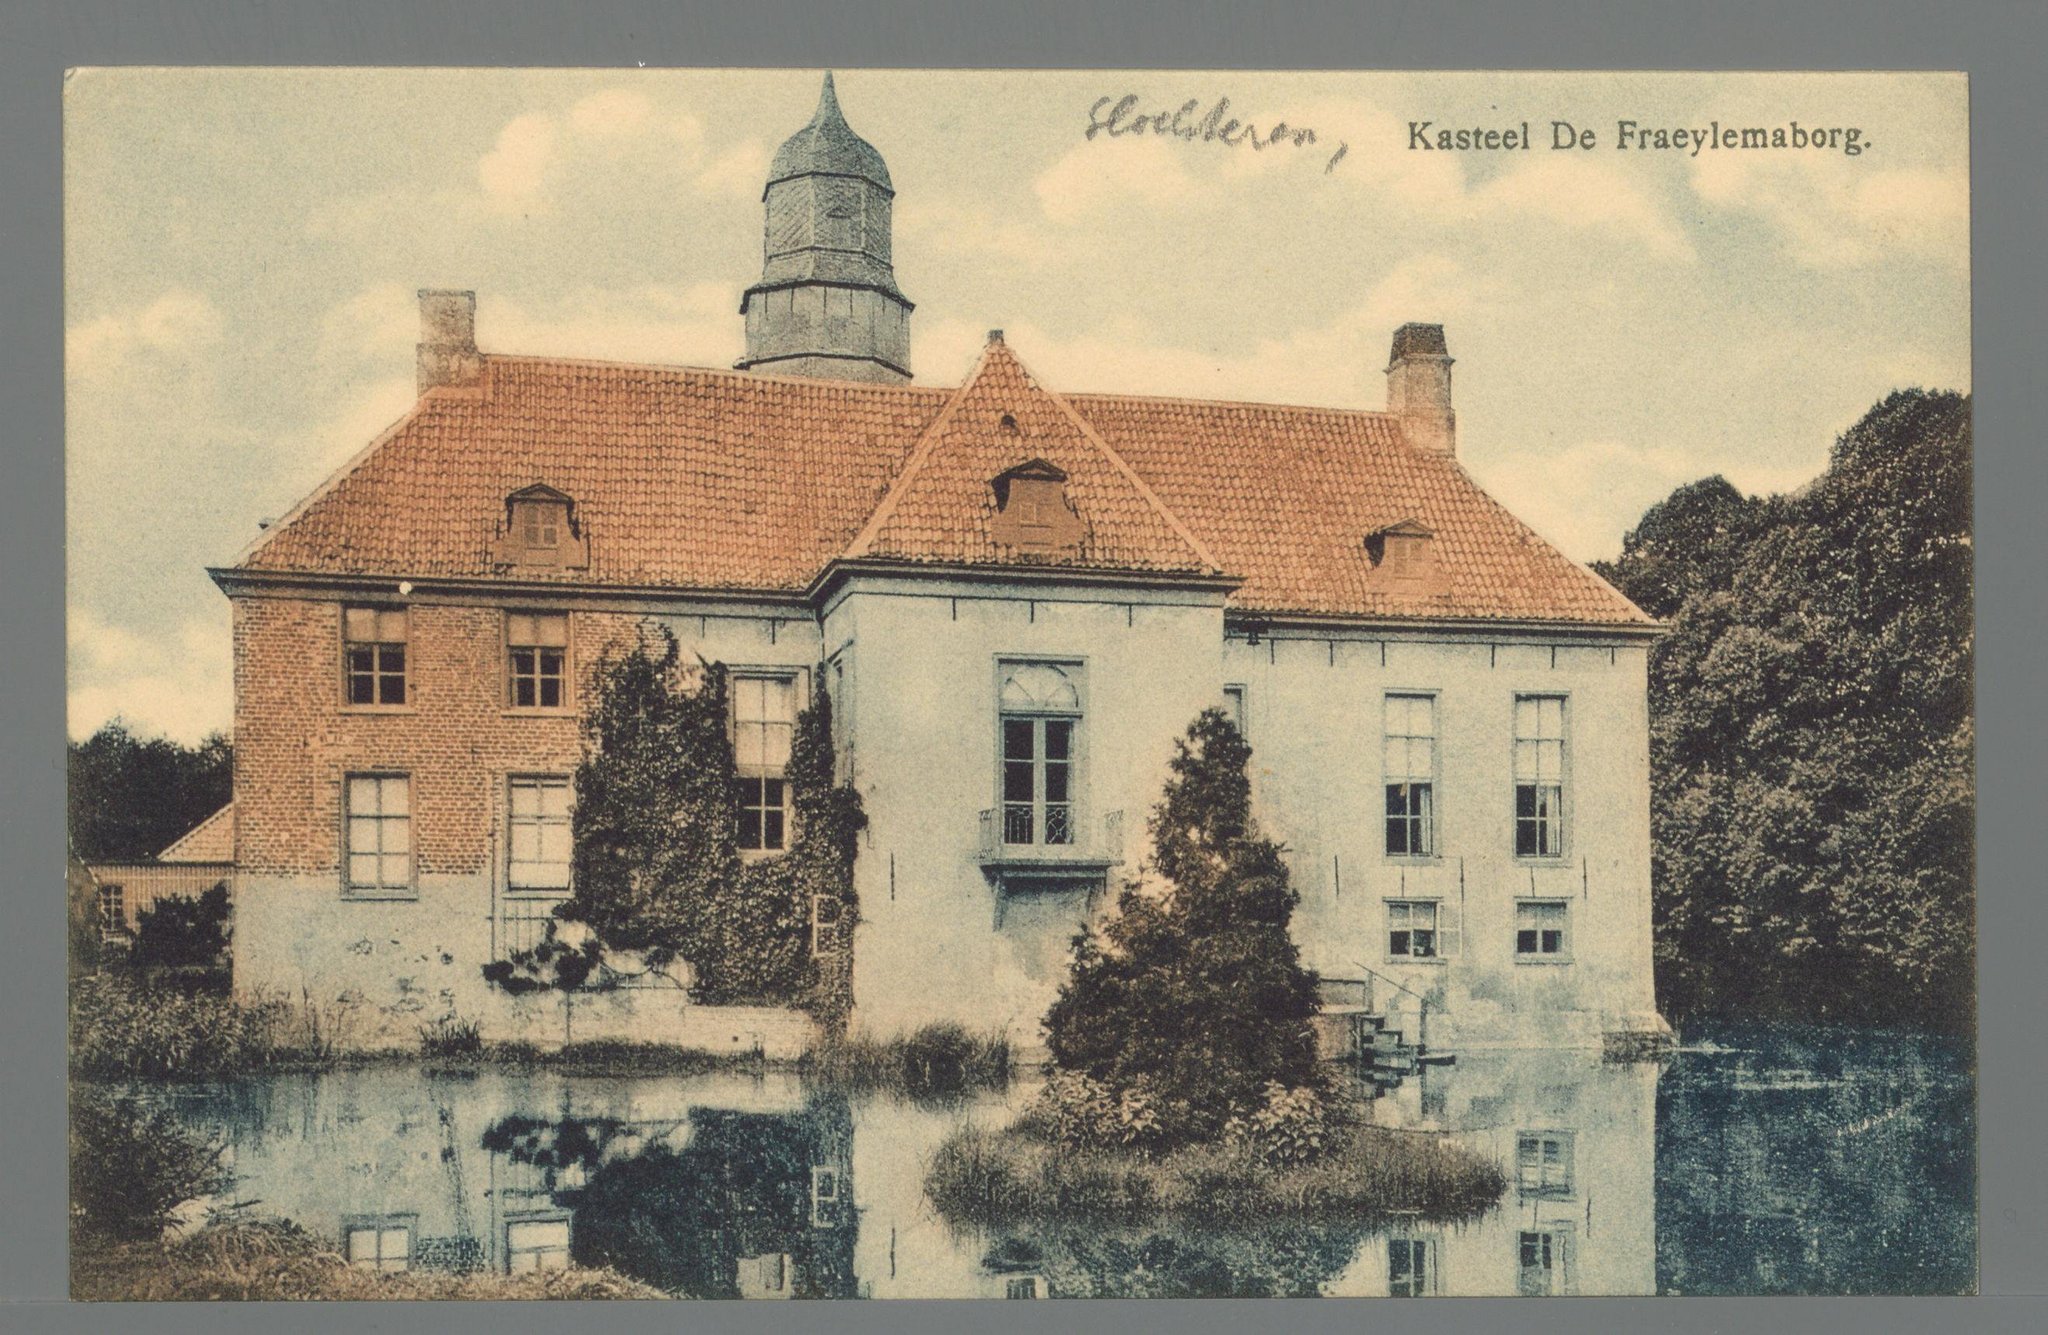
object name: photomechanical print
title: Kasteel De Fraeylemaborg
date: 1905-1930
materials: cardboard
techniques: collotype process, writing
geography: amsterdam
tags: castle, canal